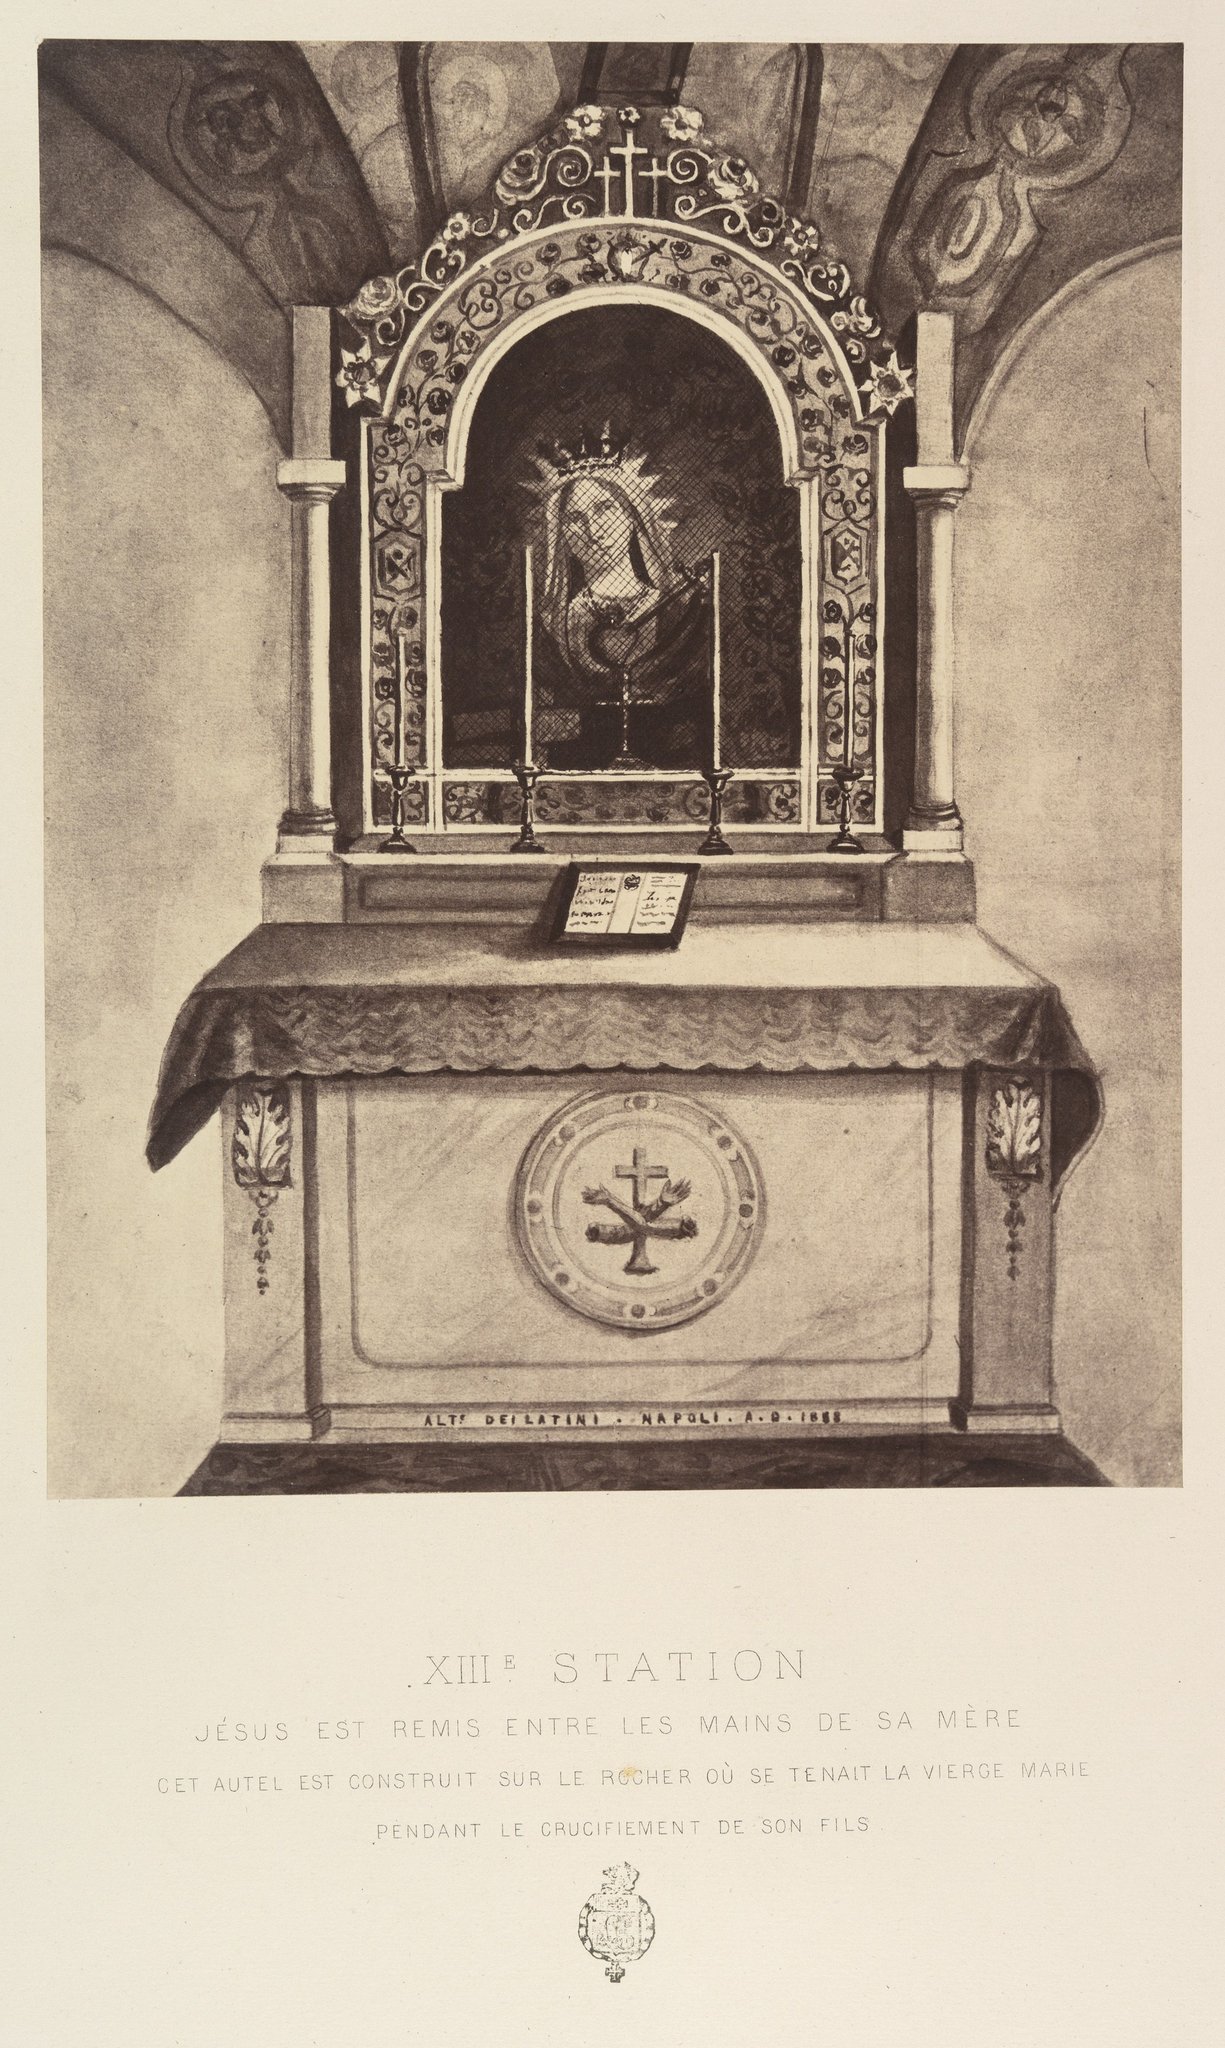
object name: photograph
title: XIIIe Station. Jésus est remis entre les mains de sa mère. Cet autel est construit sur le rocher où se tenait la vierge marie pendant le crucifiement de son fils.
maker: louis de clercq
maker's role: artist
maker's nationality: french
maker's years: 1837-1901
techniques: albumen silver print, paper negative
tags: altars,virgin mary